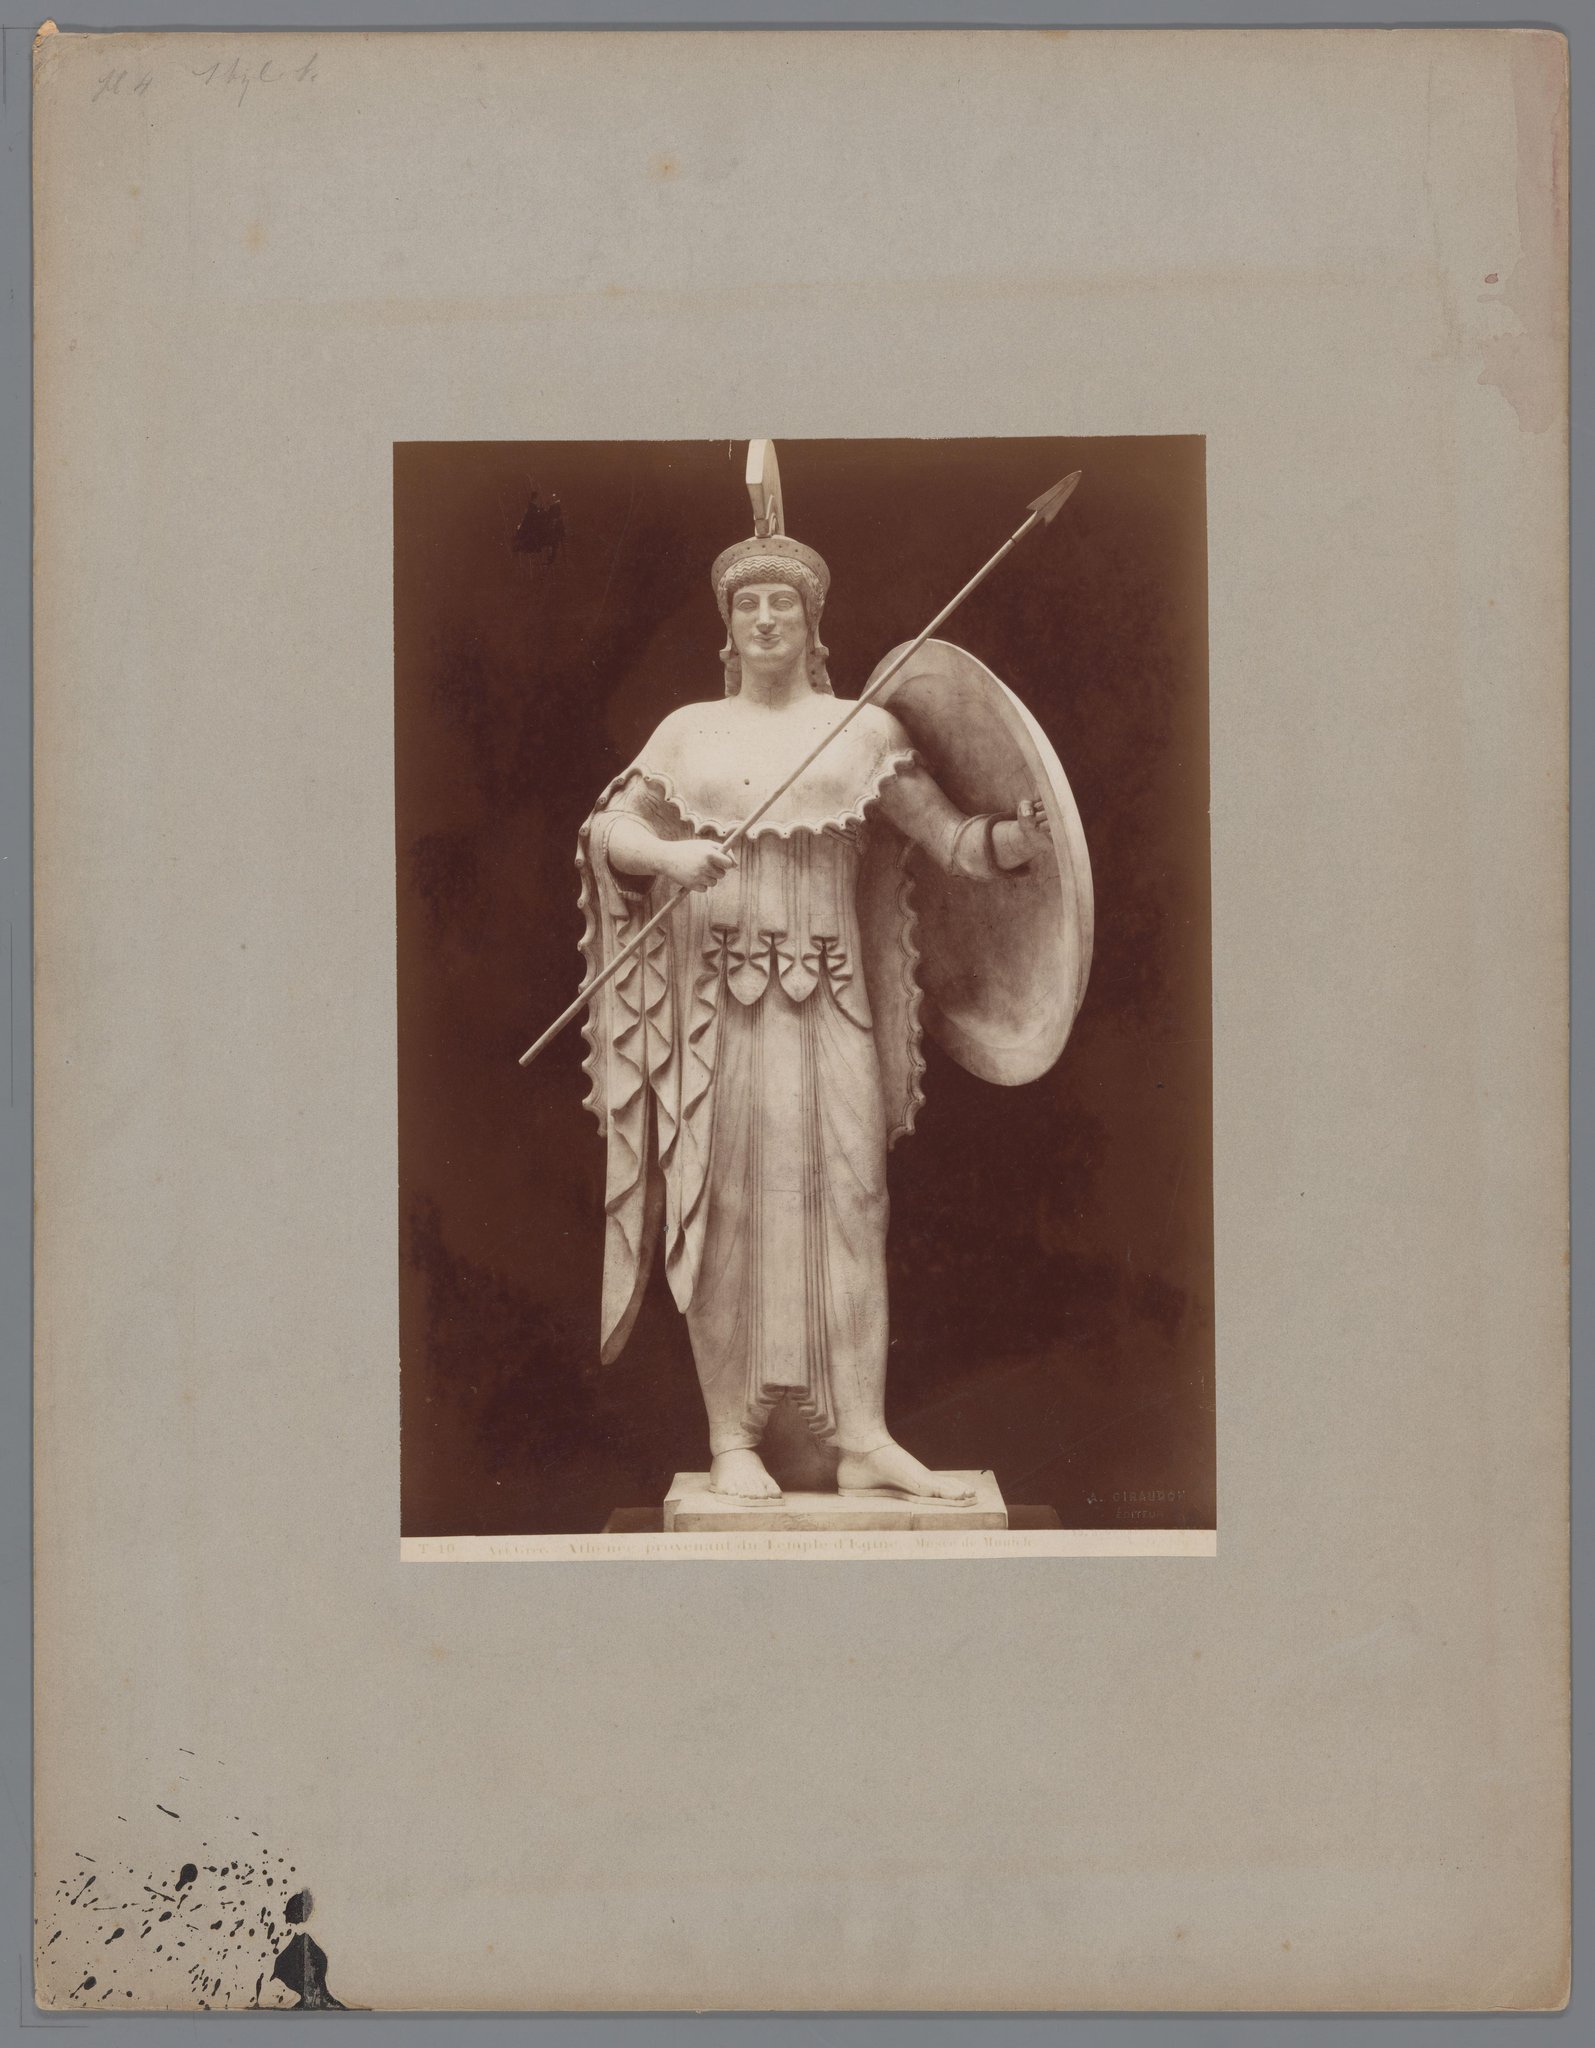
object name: photograph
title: Art Grec. - Athenée provenant du Temple d'Egine Musée de Munich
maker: adolphe giraudon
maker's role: publisher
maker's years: 1849-1929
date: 1875-1900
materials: cardboard, photographic support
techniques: albumen print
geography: paris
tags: protective weapons: shield, (story of) minerva (pallas, athena), helved weapons, polearms (for striking, hacking, thrusting): lance, sculpture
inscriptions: collector's mark: Lugt 3937, inscription: ‘pl 4 stijl k.’, name: ‘A. GIRAUDON ÉDITEUR 15. R. BONAPARTE. PARIS’, number: ‘T 10’